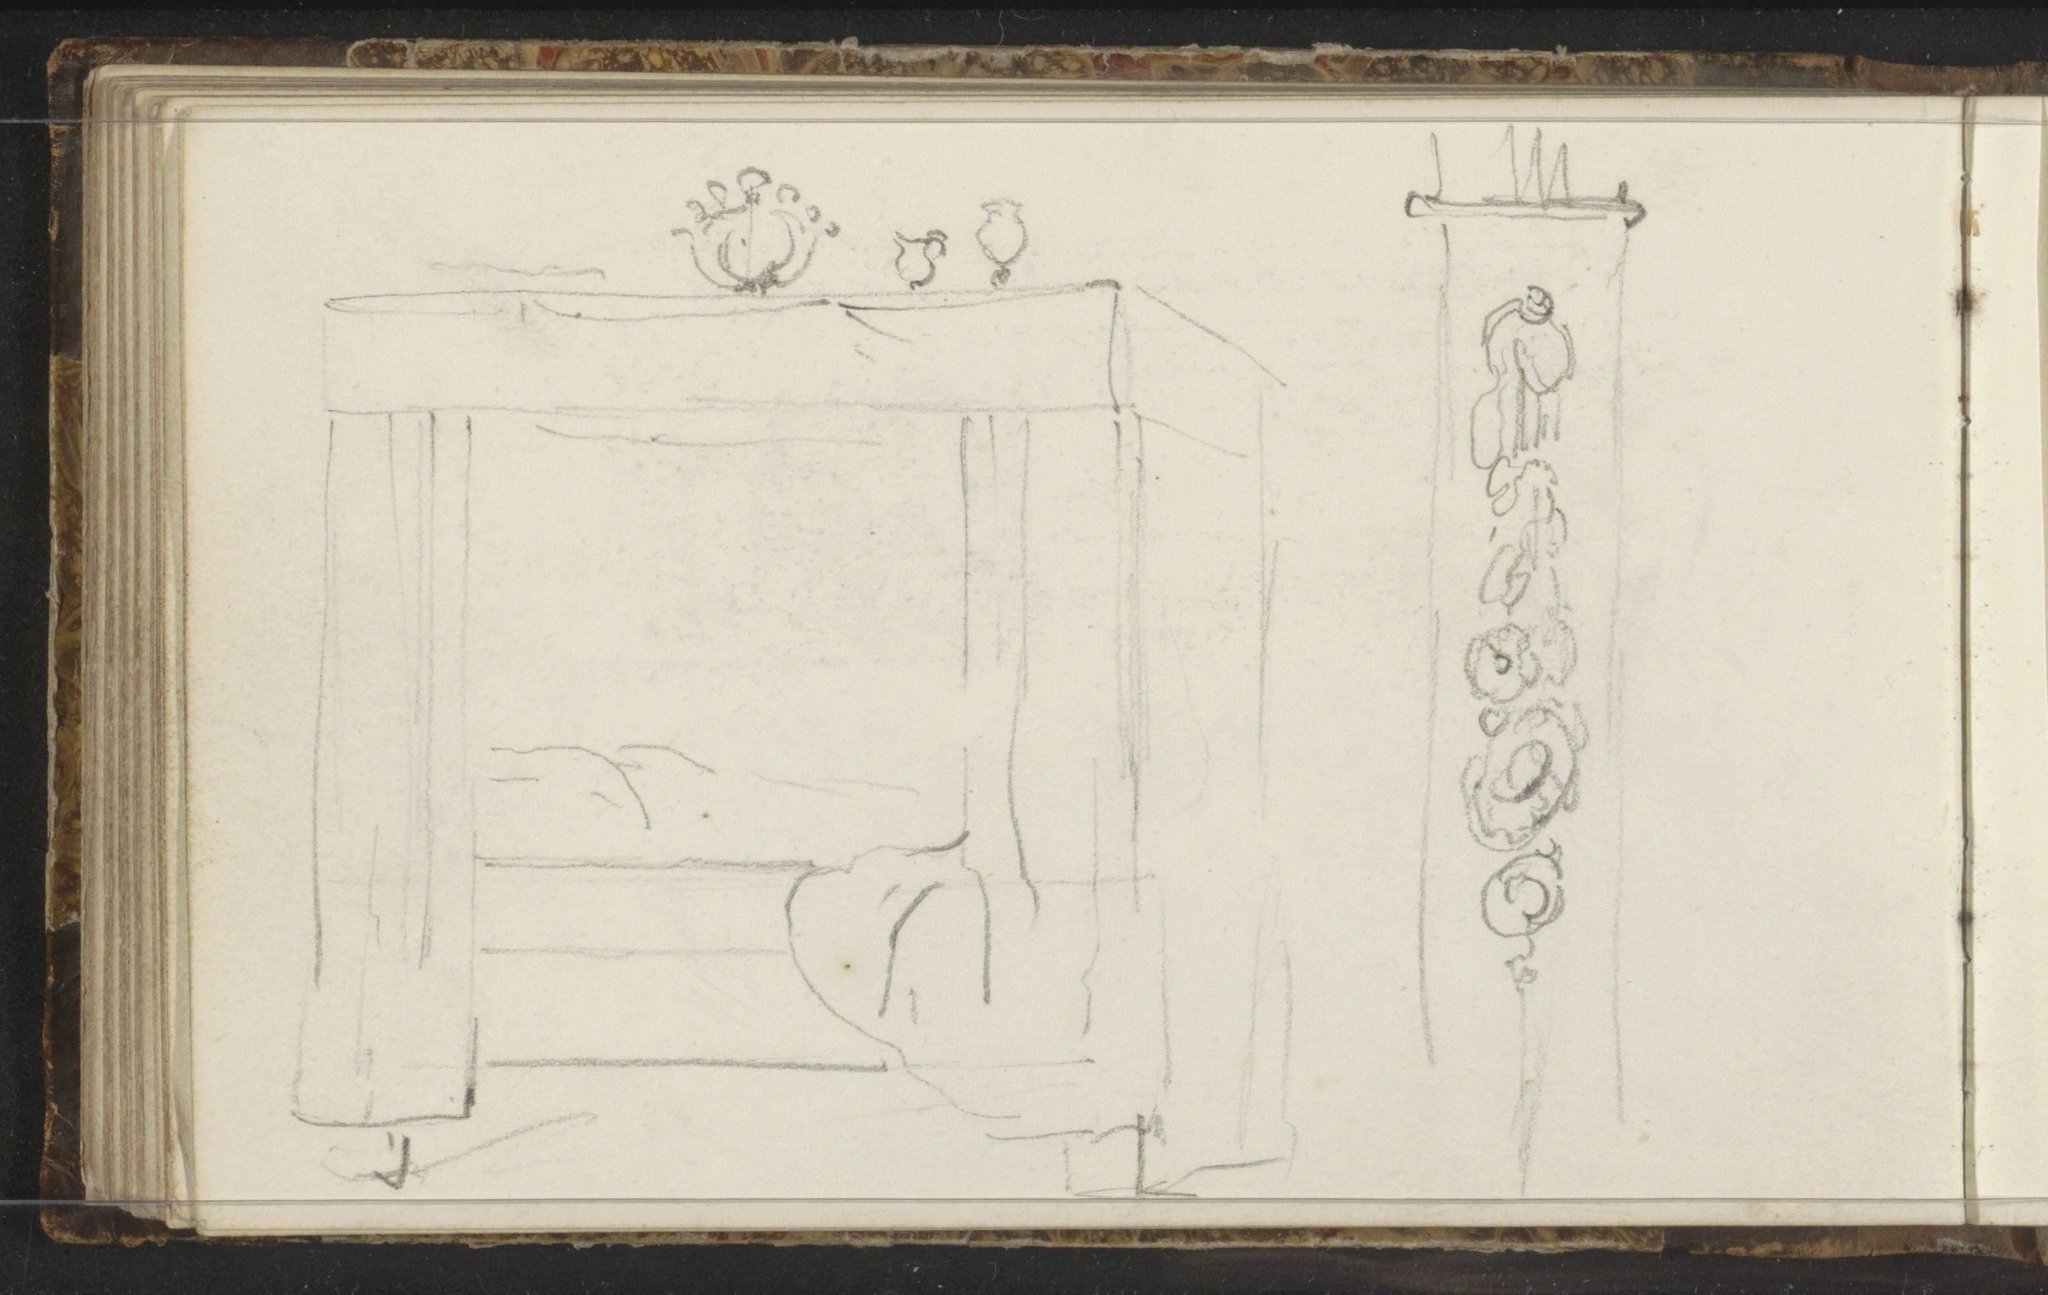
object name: sketchbook leaf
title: Hemelbed en een wandkleed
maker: willem hendrik schmidt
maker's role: draughtsman, painter, print maker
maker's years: 1809-1849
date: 1819-1849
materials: paper, pencil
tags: tapestry, four poster bed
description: Blad 41 verso uit een schetsboek met 60 bladen.